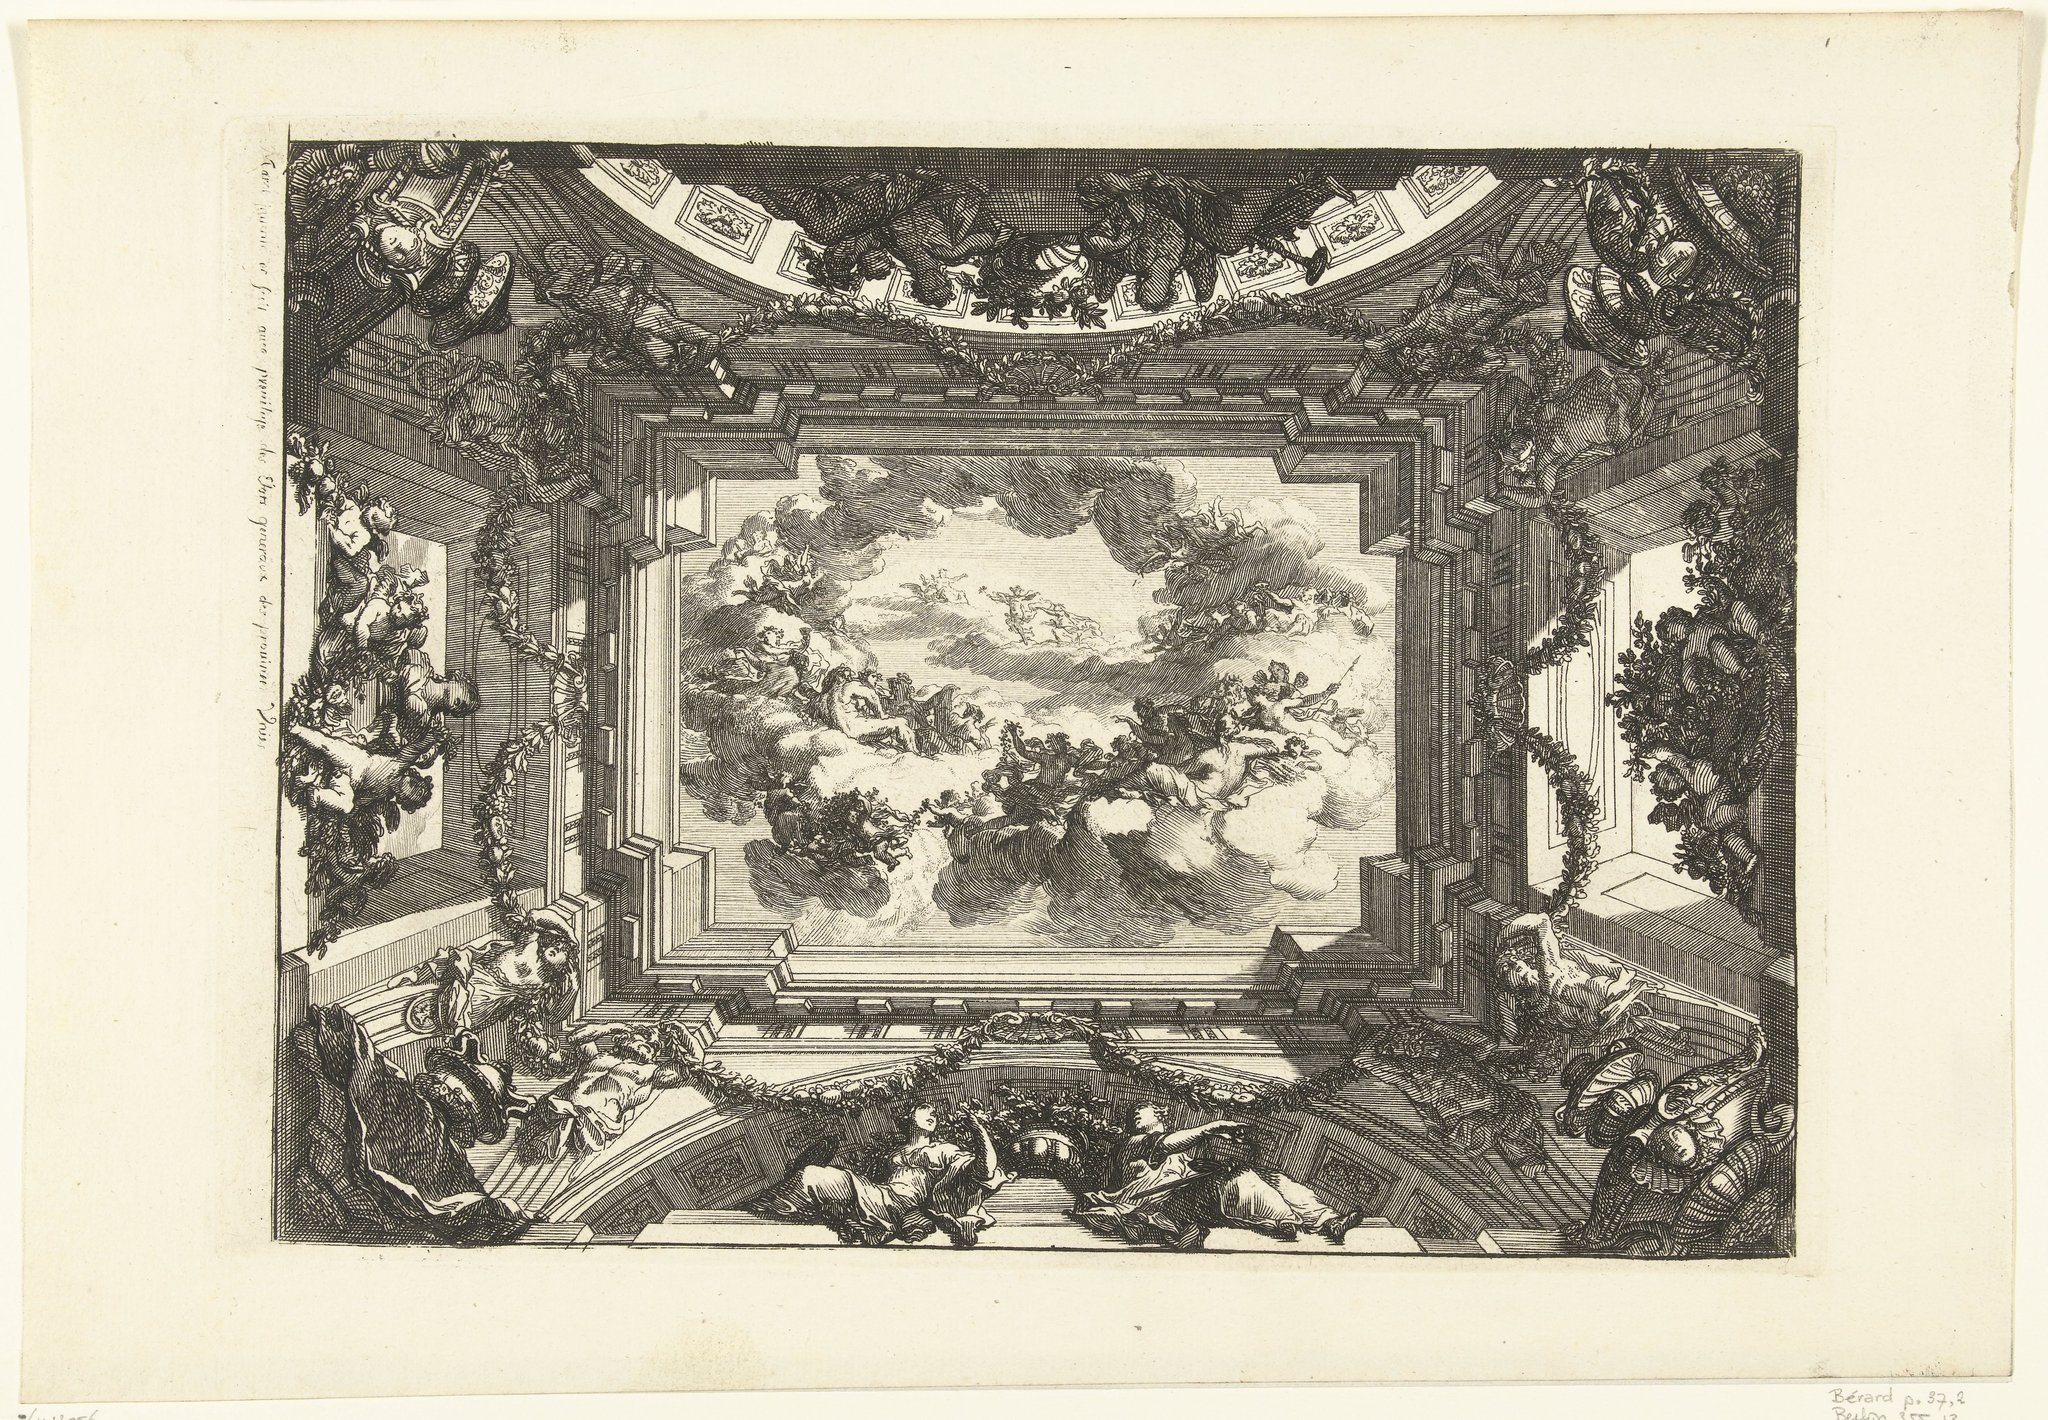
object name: ornament print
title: Plafonds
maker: daniël marot (i)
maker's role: draughtsman, print maker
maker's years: 1661-1752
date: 1712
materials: paper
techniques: etching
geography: netherlands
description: Plafond met rechthoekig middenstuk met een mythologische voorstelling gesteund door termen. De lange zijden gesteund door twee bogen. In de hoeken zijn consoles met een masker en een vaas te zien. Uit serie van 6 (mogelijk 12) bladen.